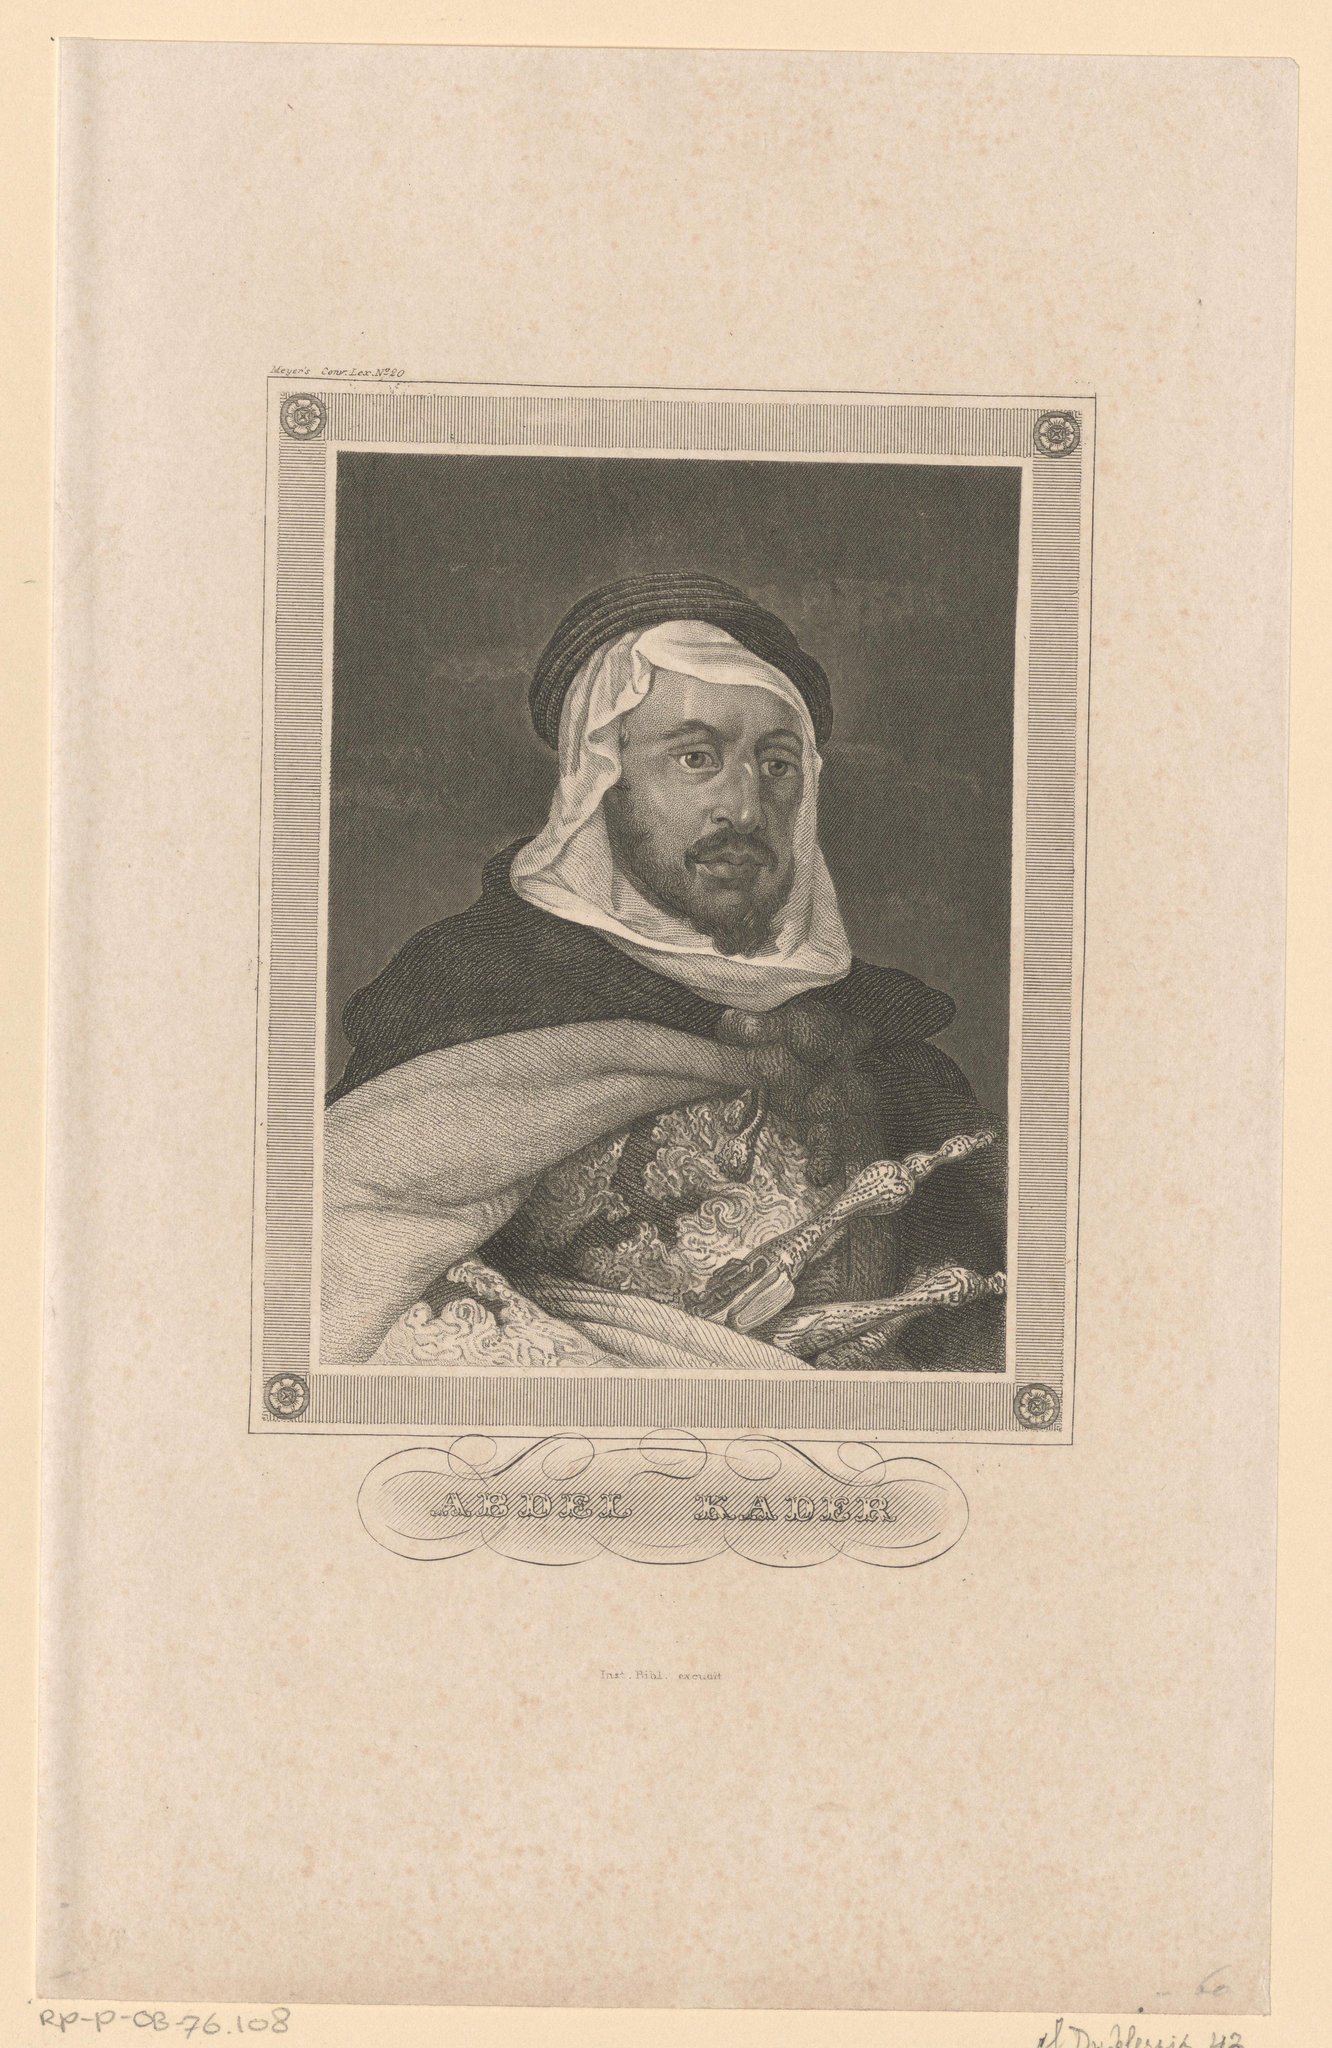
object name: print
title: Portret van Abd el-Kader, bey van Mascara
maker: Anonymous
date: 1839-1868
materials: paper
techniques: engraving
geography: hildburghausen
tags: abd al- kader (bey van mascara)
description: Portret van Abd el-Kader in een geornamenteerde, rechthoekige omlijsting. In de ondermarge zijn naam. Linksboven: Meyer's Conv.Lex.No 20.